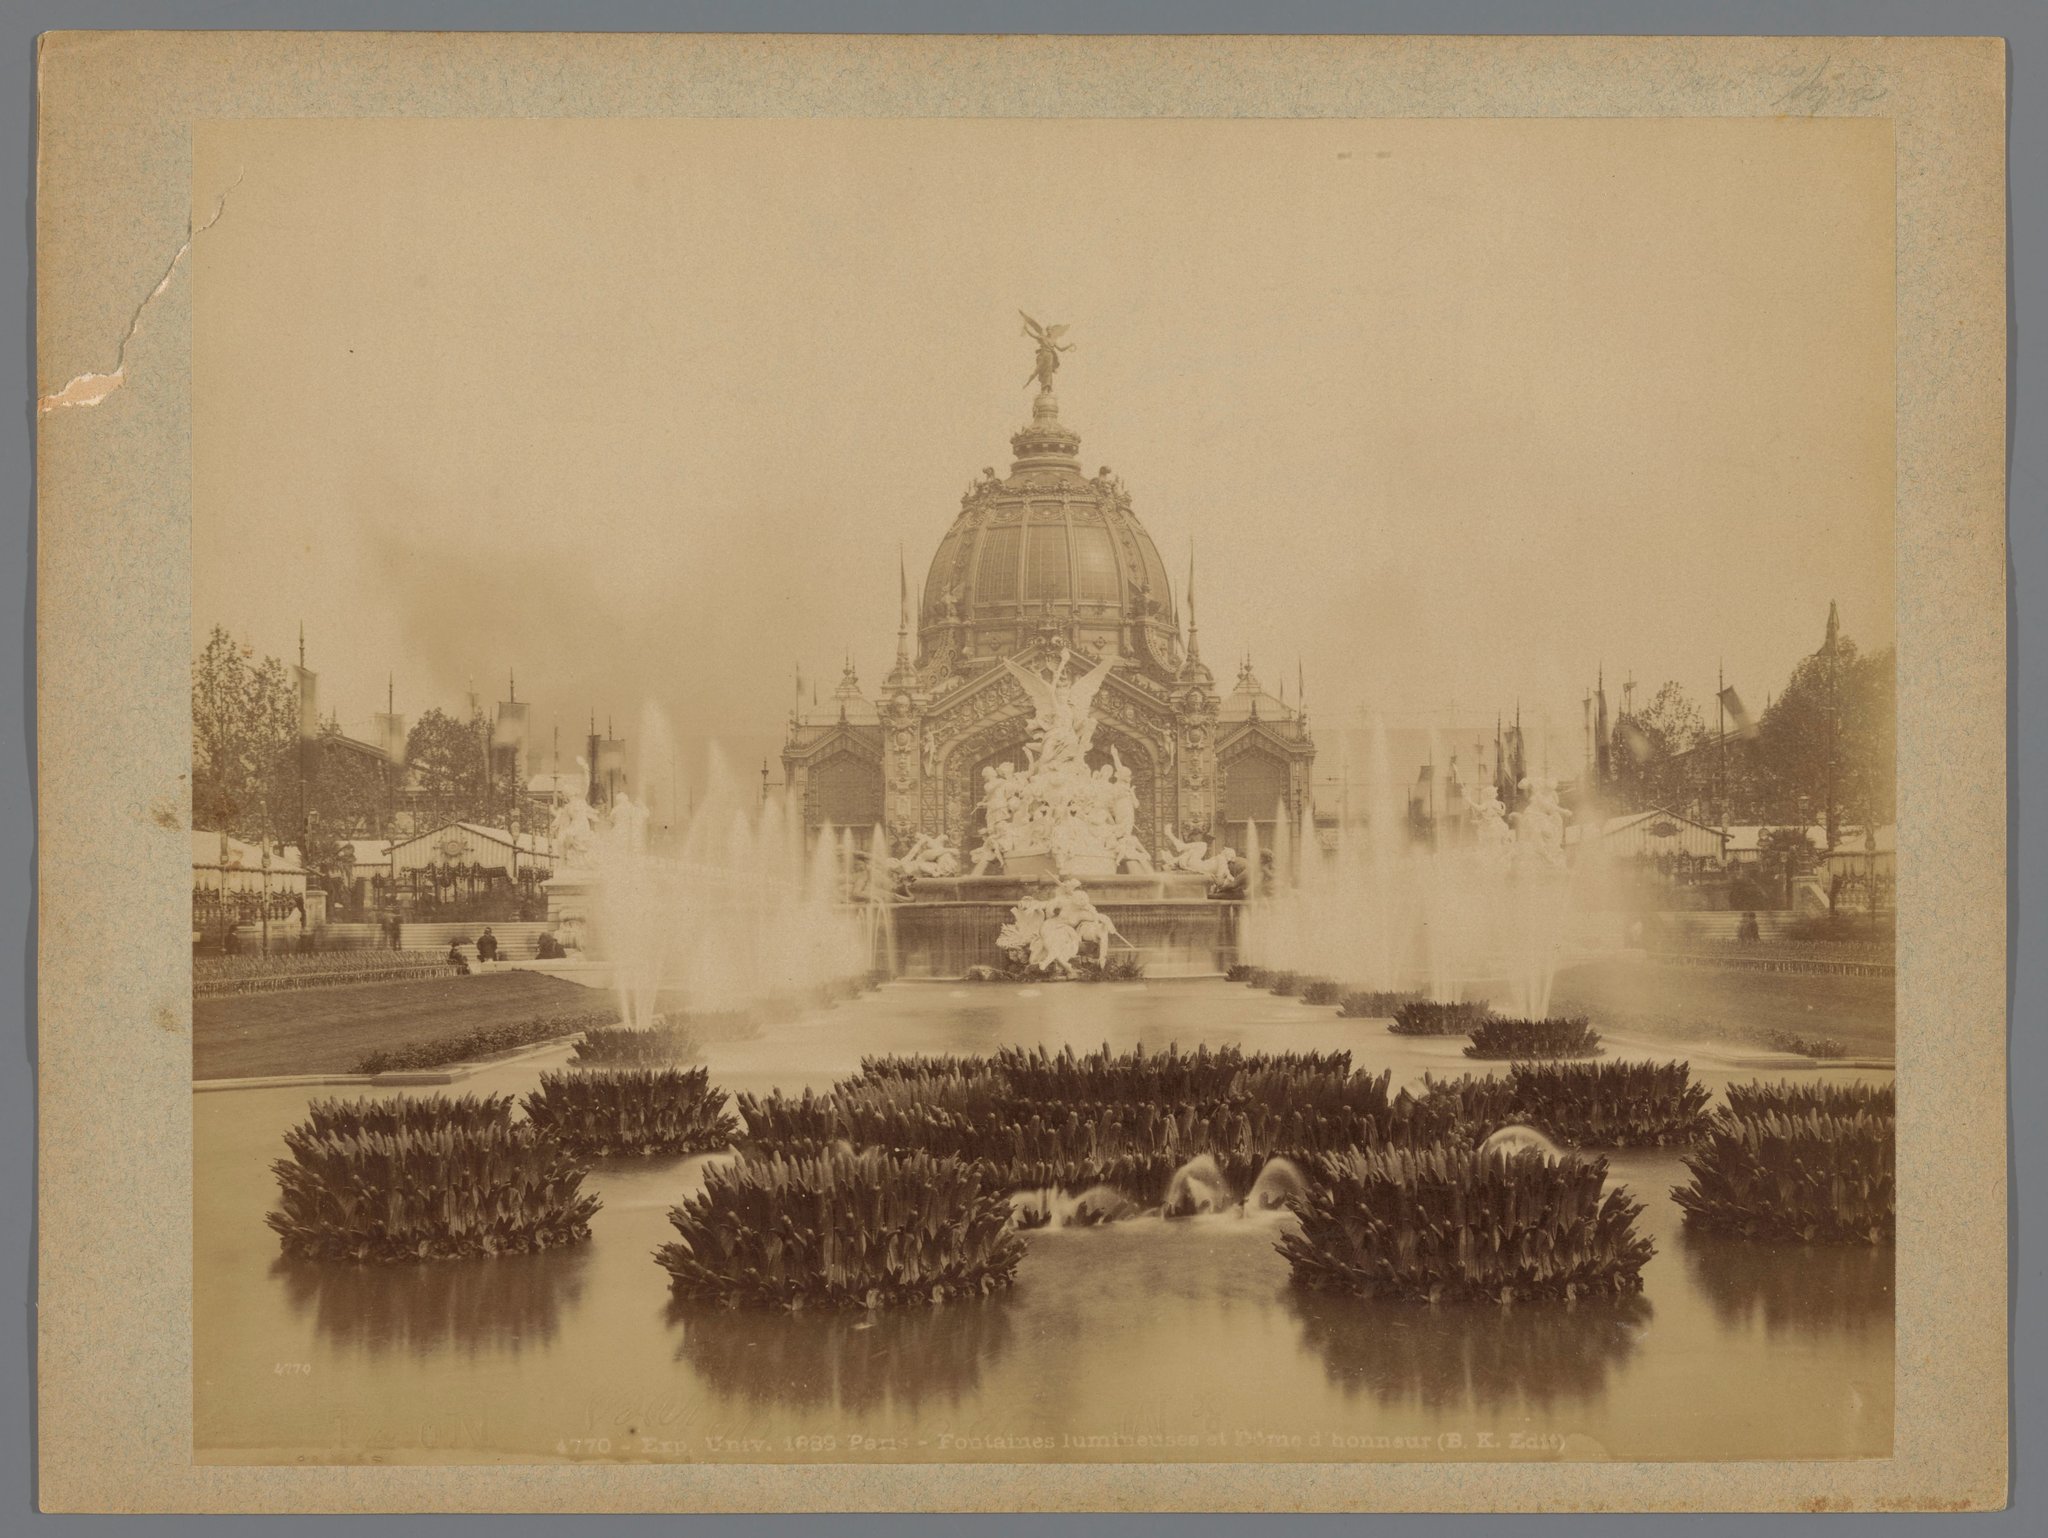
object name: photograph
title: Exp. Univ. 1889 Paris - Fontaines lumineuses et Dôme d'honneur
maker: Anonymous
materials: cardboard, photographic support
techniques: albumen print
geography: paris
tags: monument, statue, façade (of house or building), dome ~ architecture, ornamental fountain (+ city(-scape) with figures, staffage), public gardens, park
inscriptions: collector's mark: Lugt 3937, number: ‘4770’